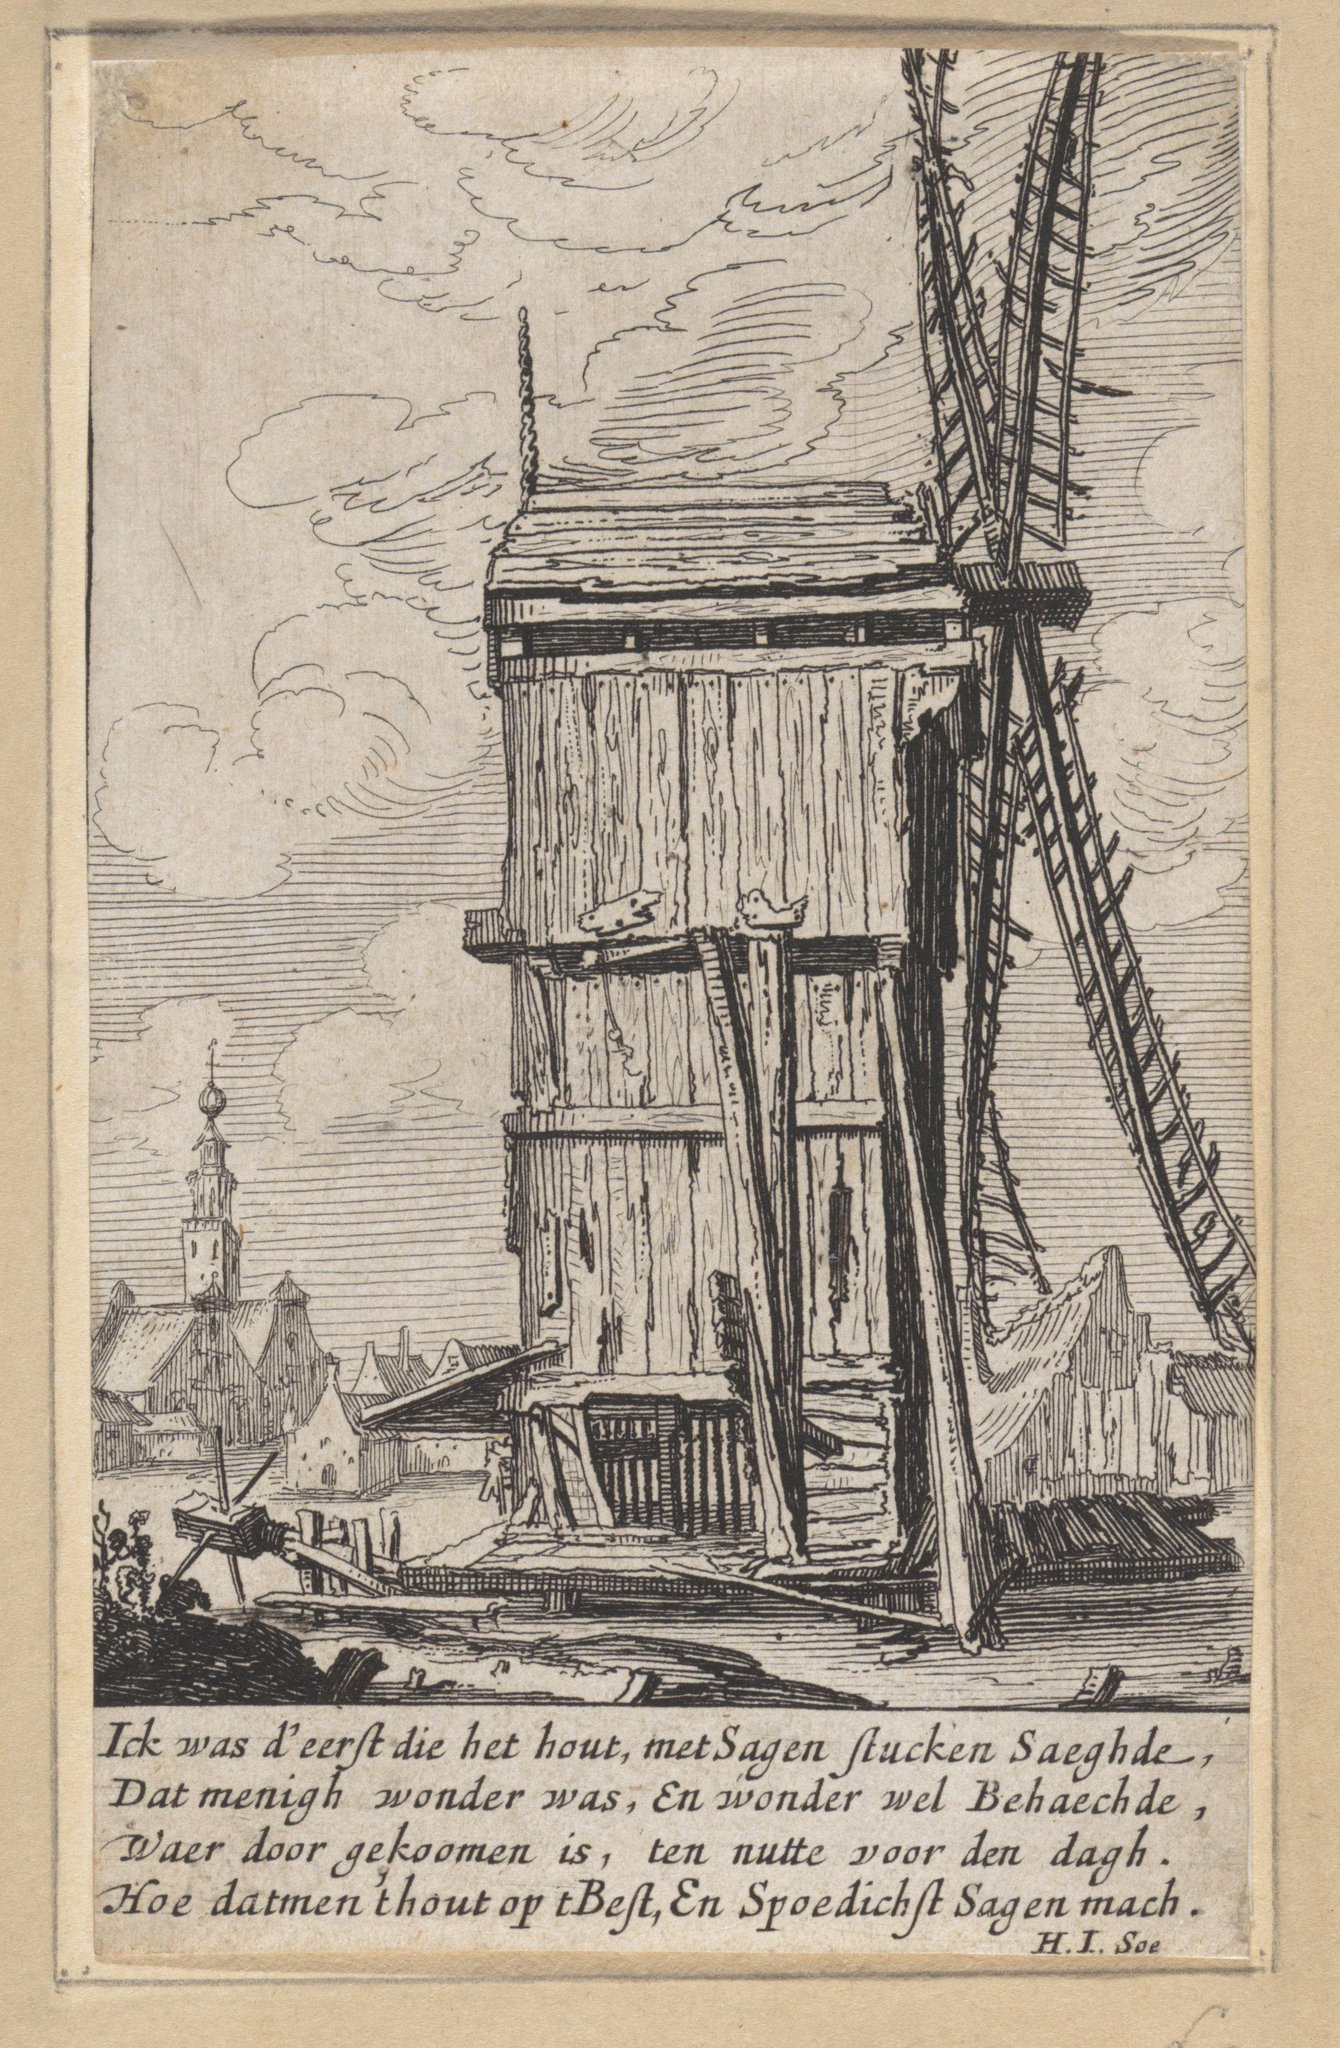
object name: print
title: Zaagmolen 'Het Juffertje' in Zaandam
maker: hendrik jacobsz soeteboom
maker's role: print maker, publisher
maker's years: 1616-1678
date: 1631-1678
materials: paper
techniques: engraving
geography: zaandam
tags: saw-mill (works), windmill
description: De allereerste door windkracht aangedreven zaagmolen, genaamd 'het Juffertje'. De molen werd uitgevonden door Cornelis Cornelisz van Uitgeest. De molen stond op een vlot om hem naar de wind te kunnen draaien. Onder de prent een lofdicht in het Nederlands op deze allereerste zaagmolen.